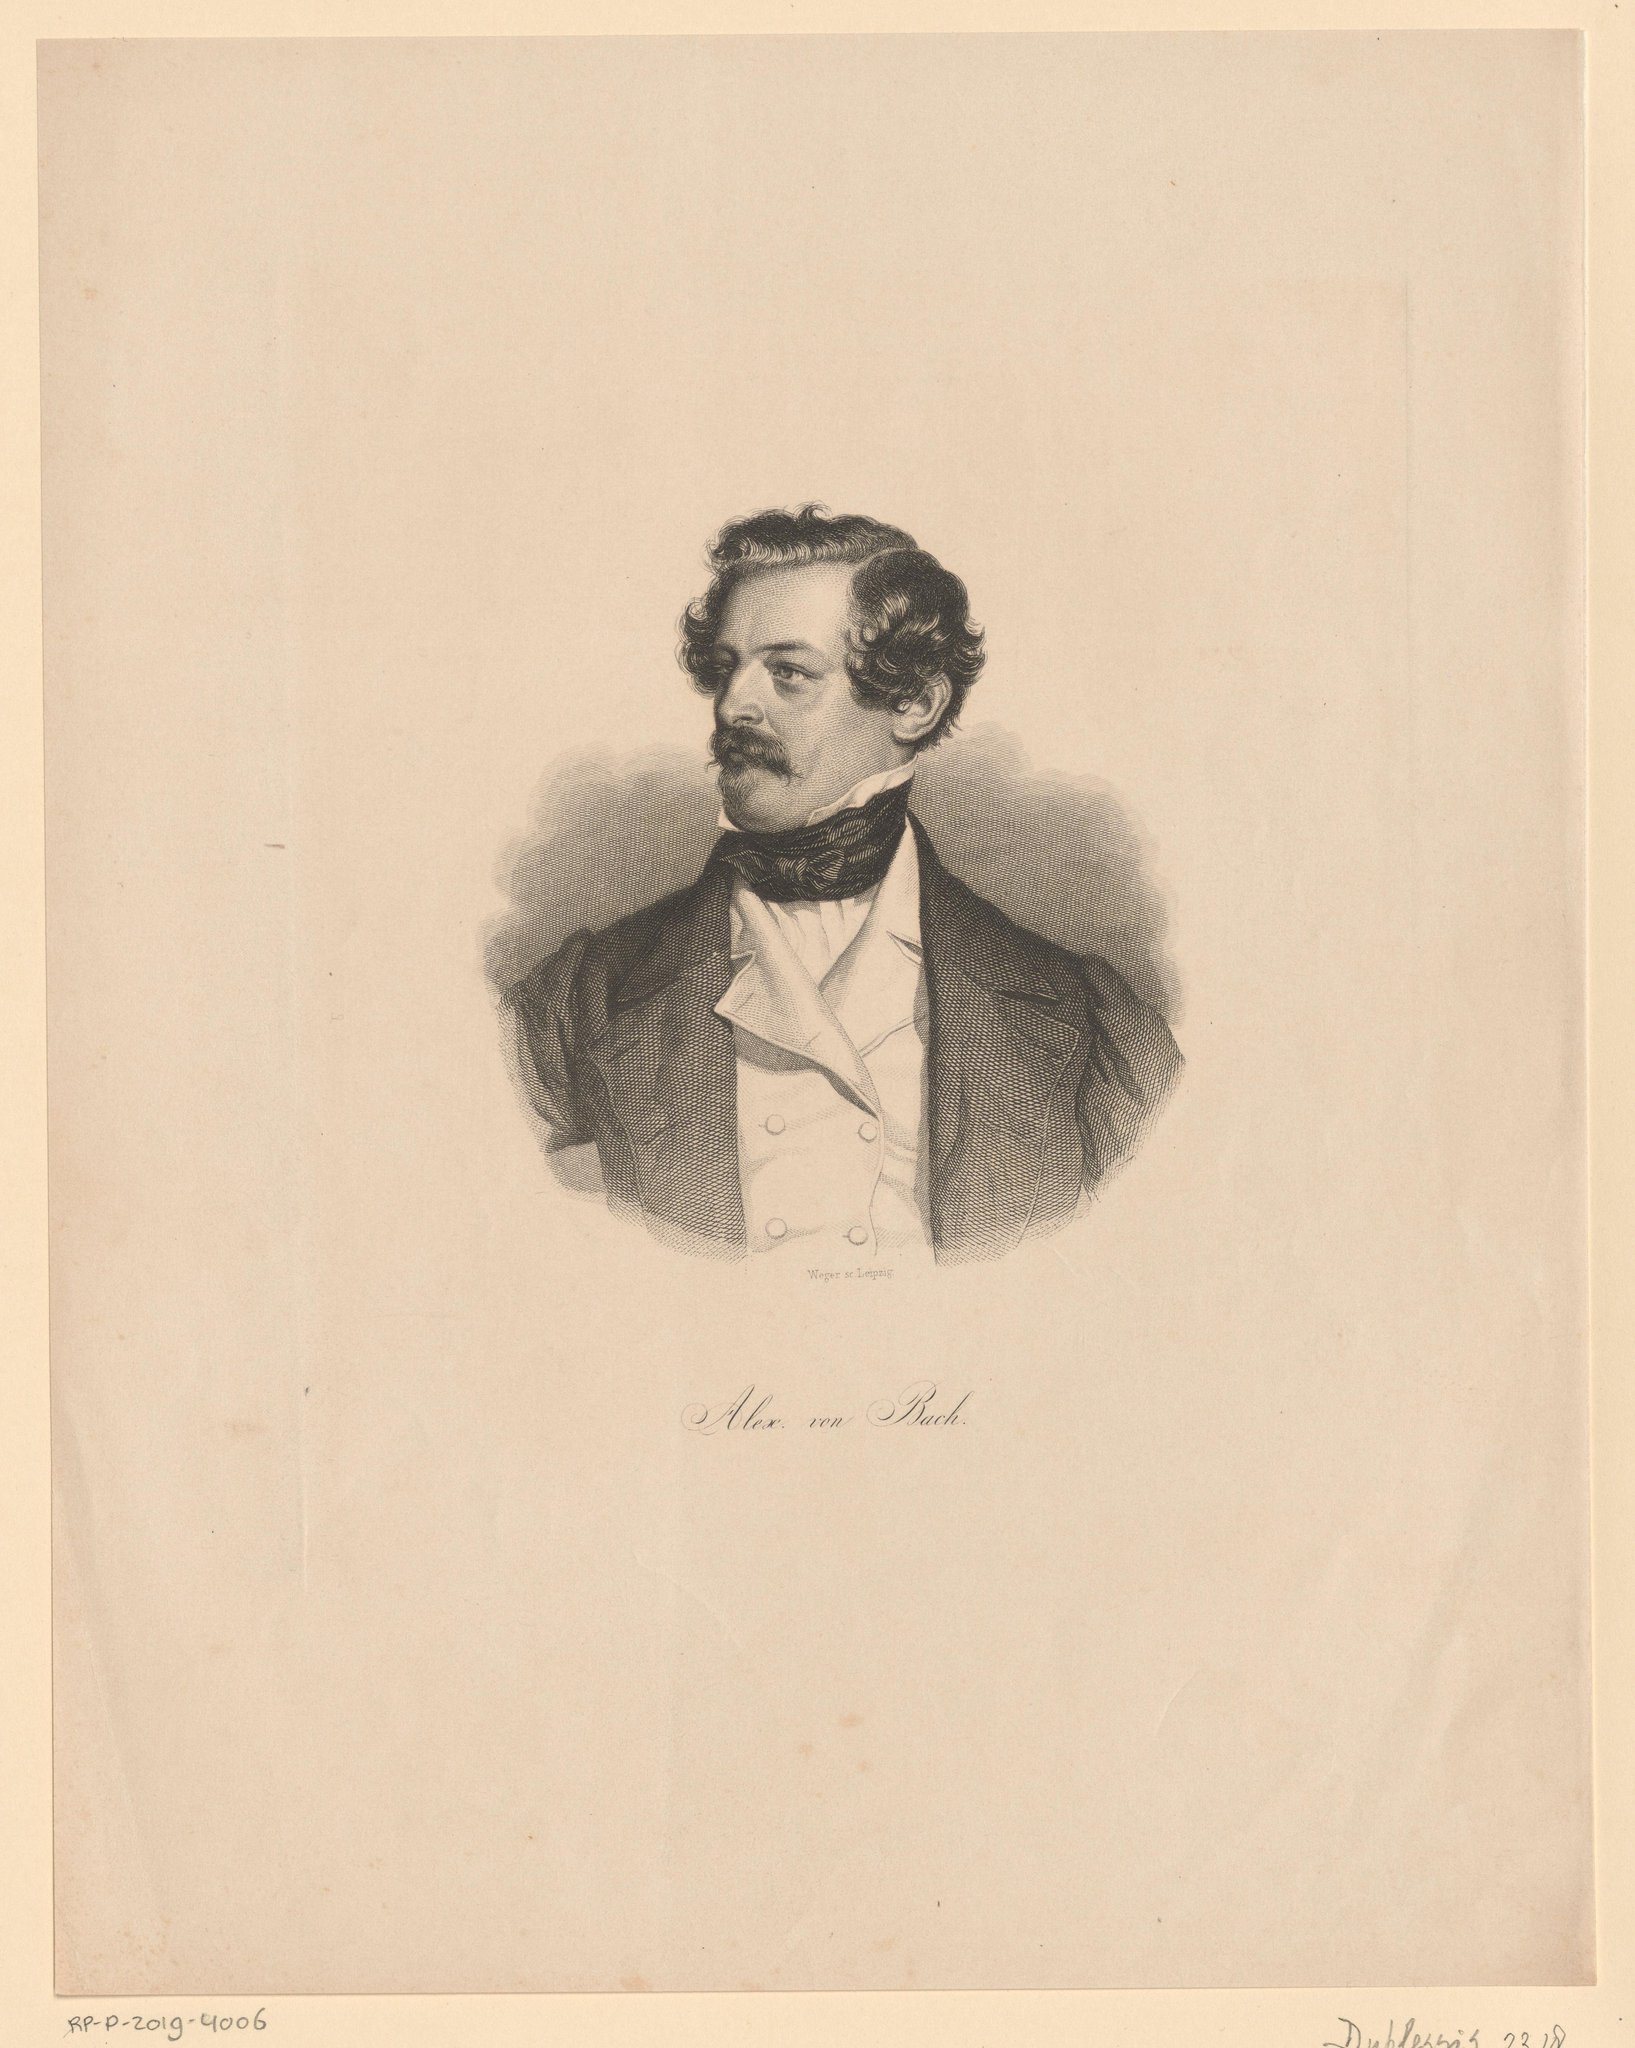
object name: print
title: Portret van Alexander von Bach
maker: august weger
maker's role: print maker, printer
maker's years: 1823-1892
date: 1833-1892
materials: paper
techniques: engraving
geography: leipzig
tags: historical persons